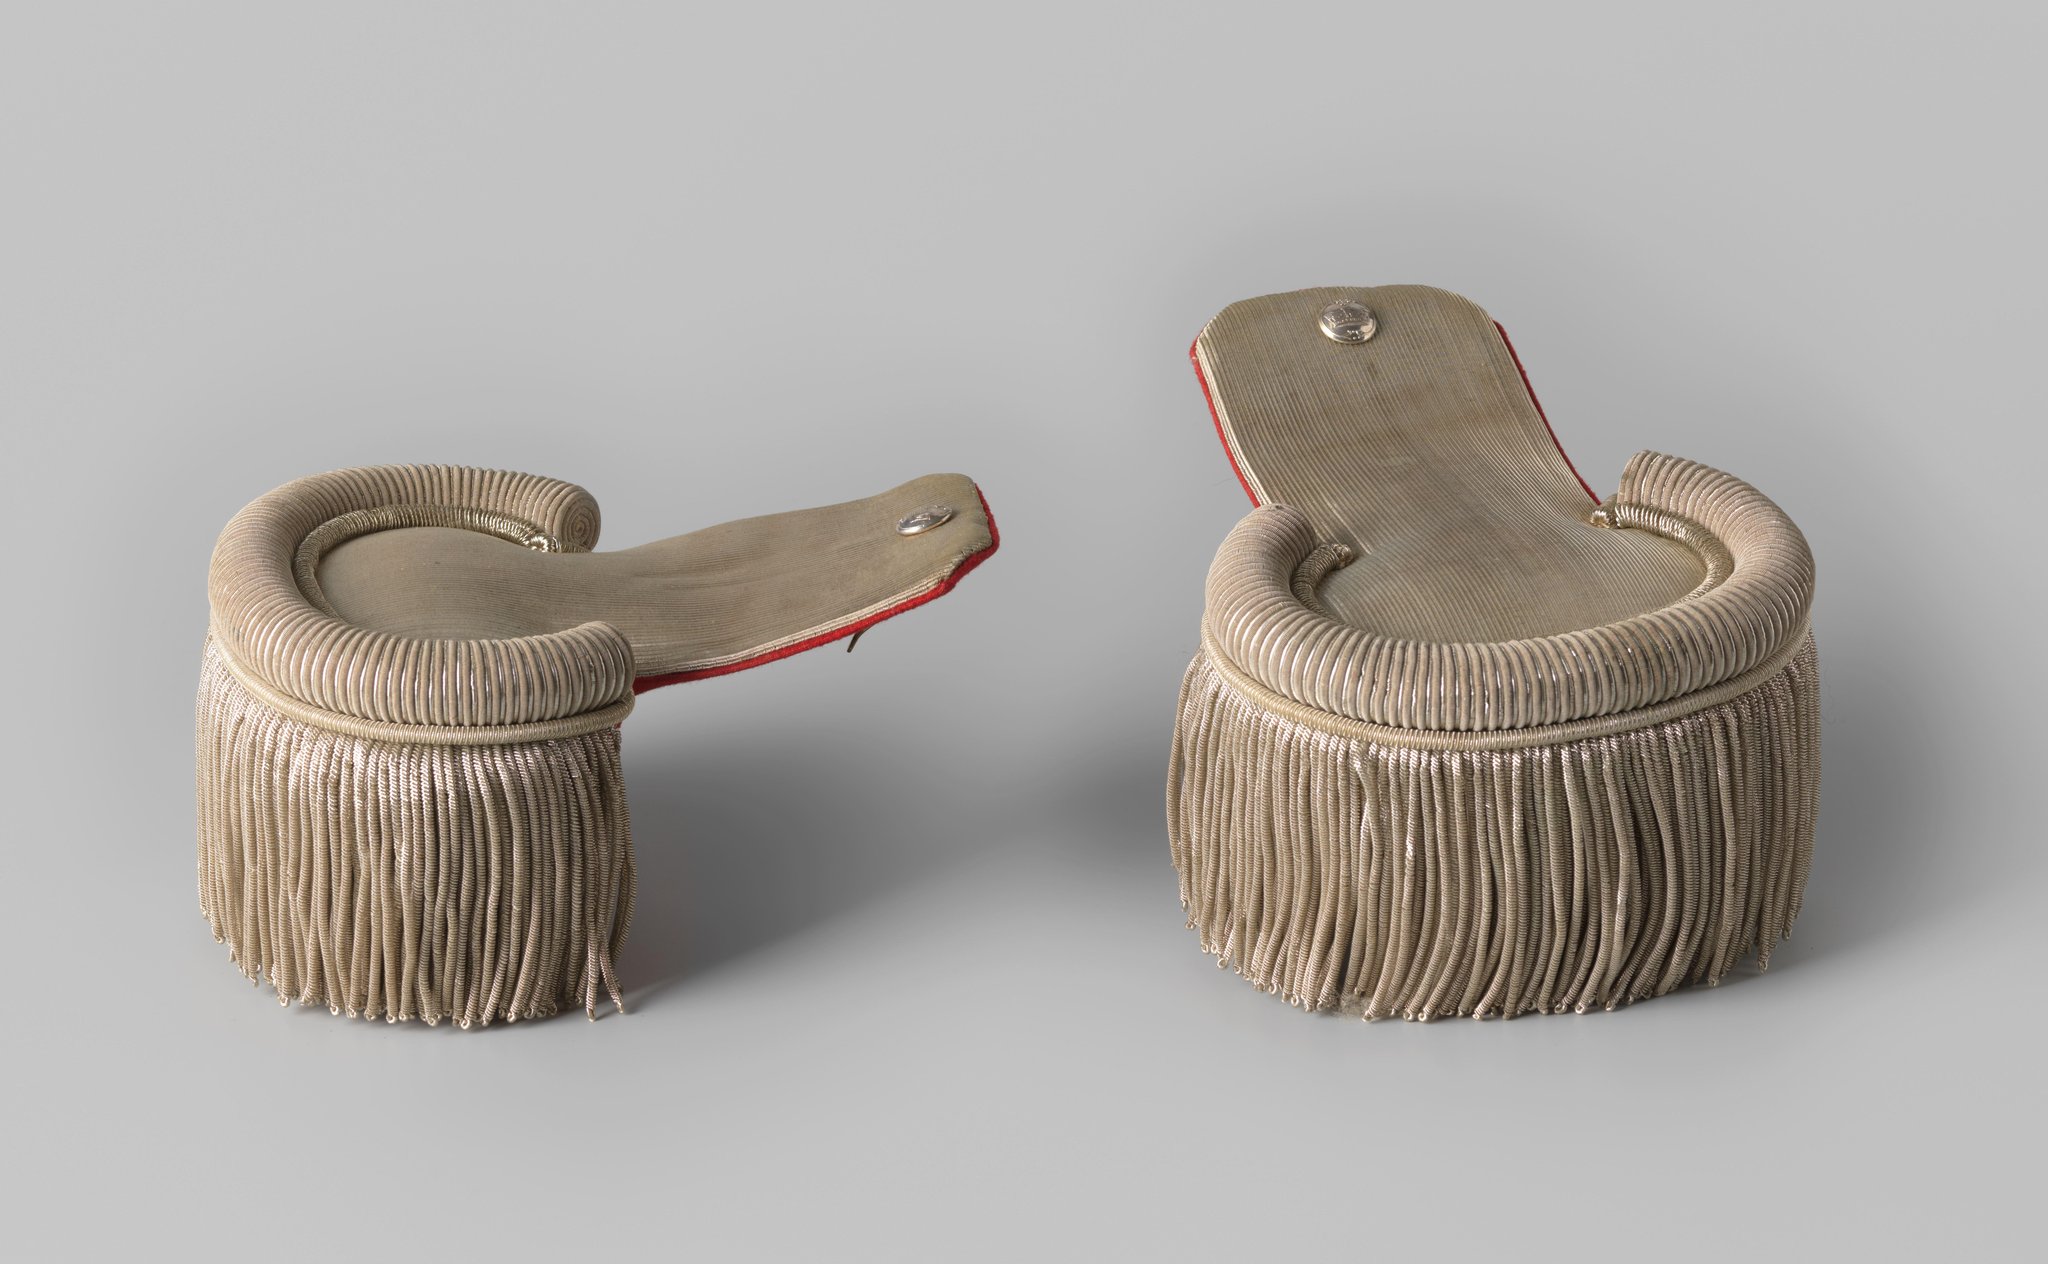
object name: schutterij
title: Epaulet van effen zilverbrokaat en een blank knoopje met muurkroon op rode wollen of baaien bies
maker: a. de block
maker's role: manufacturer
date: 1800-1850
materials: copper, metal, paper, ink, silk, thread, wool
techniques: printing, weave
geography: amsterdam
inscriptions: name: ‘Goud en Zilvertrekkerij/ Fabriek van Gouden en Zilveren/ EPAULETTEN/ Galonnen Borduursels/ en Militaire Ornamenten/ A. de BLOCK/ Warmoesstraat No.21/ AMSTERDAM’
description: Epaulet van effen zilverbrokaat en een blank knoopje met muurkroon op rode wollen of baaien bies. Model: vlak schouderdeel. Aan de binnenkant een halve kussenrug, opgestopt en met blauwe wol bekleed. Met lange koperen haak voor bevestiging op de jas. Versiering: elipsvormige open wrong, gevat in een fijner canetillekoord, waaronder fijne torsades of franjes hangen.